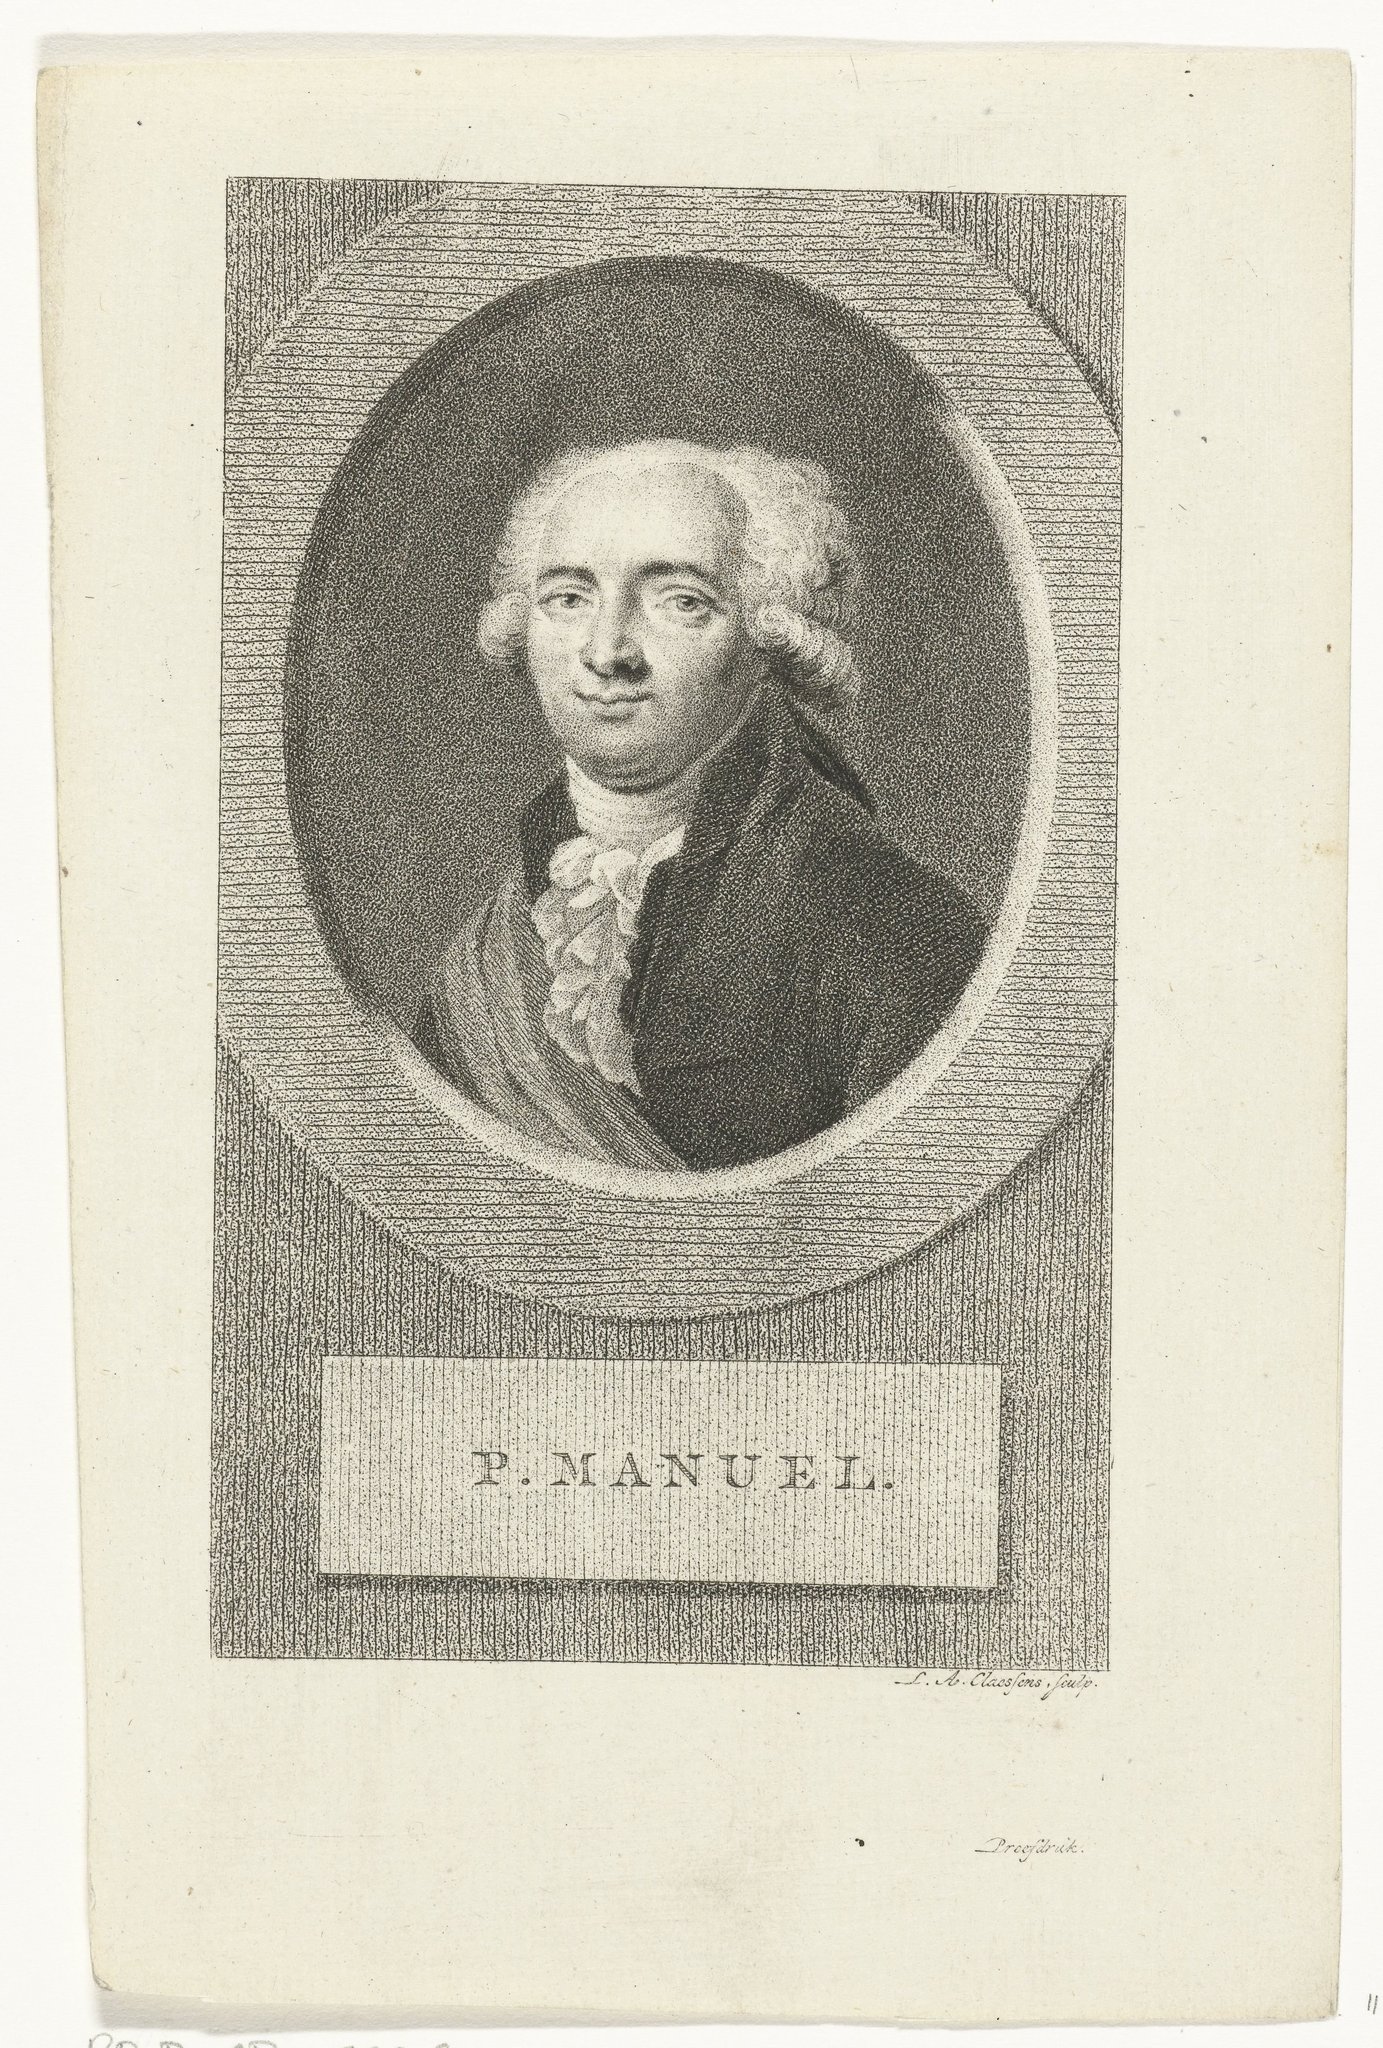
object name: print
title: Portret van Pierre Louis Manuel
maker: lambertus antonius claessens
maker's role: draughtsman, print maker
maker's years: 1763-1834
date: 1792-1808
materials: paper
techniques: engraving, etching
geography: amsterdam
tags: schrijver, revolutionair, pierre louis manuel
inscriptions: collector's mark: Lugt 2228